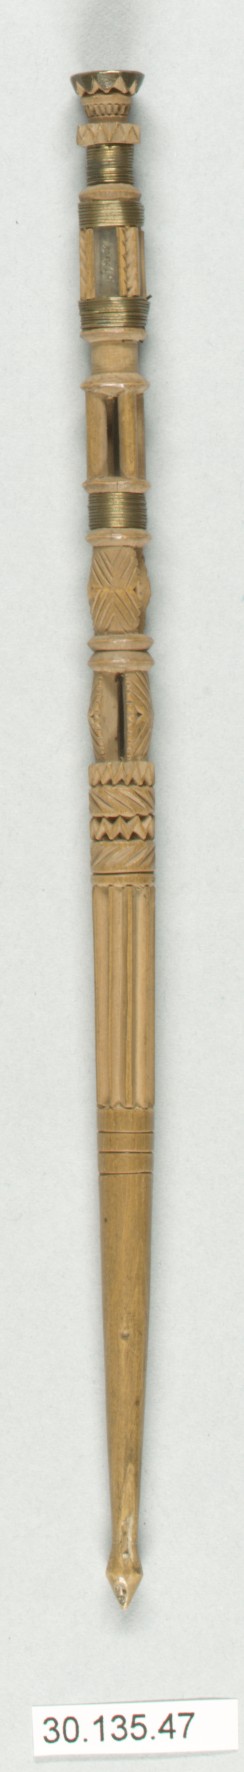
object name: needle sheath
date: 1701-1900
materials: metal, wood